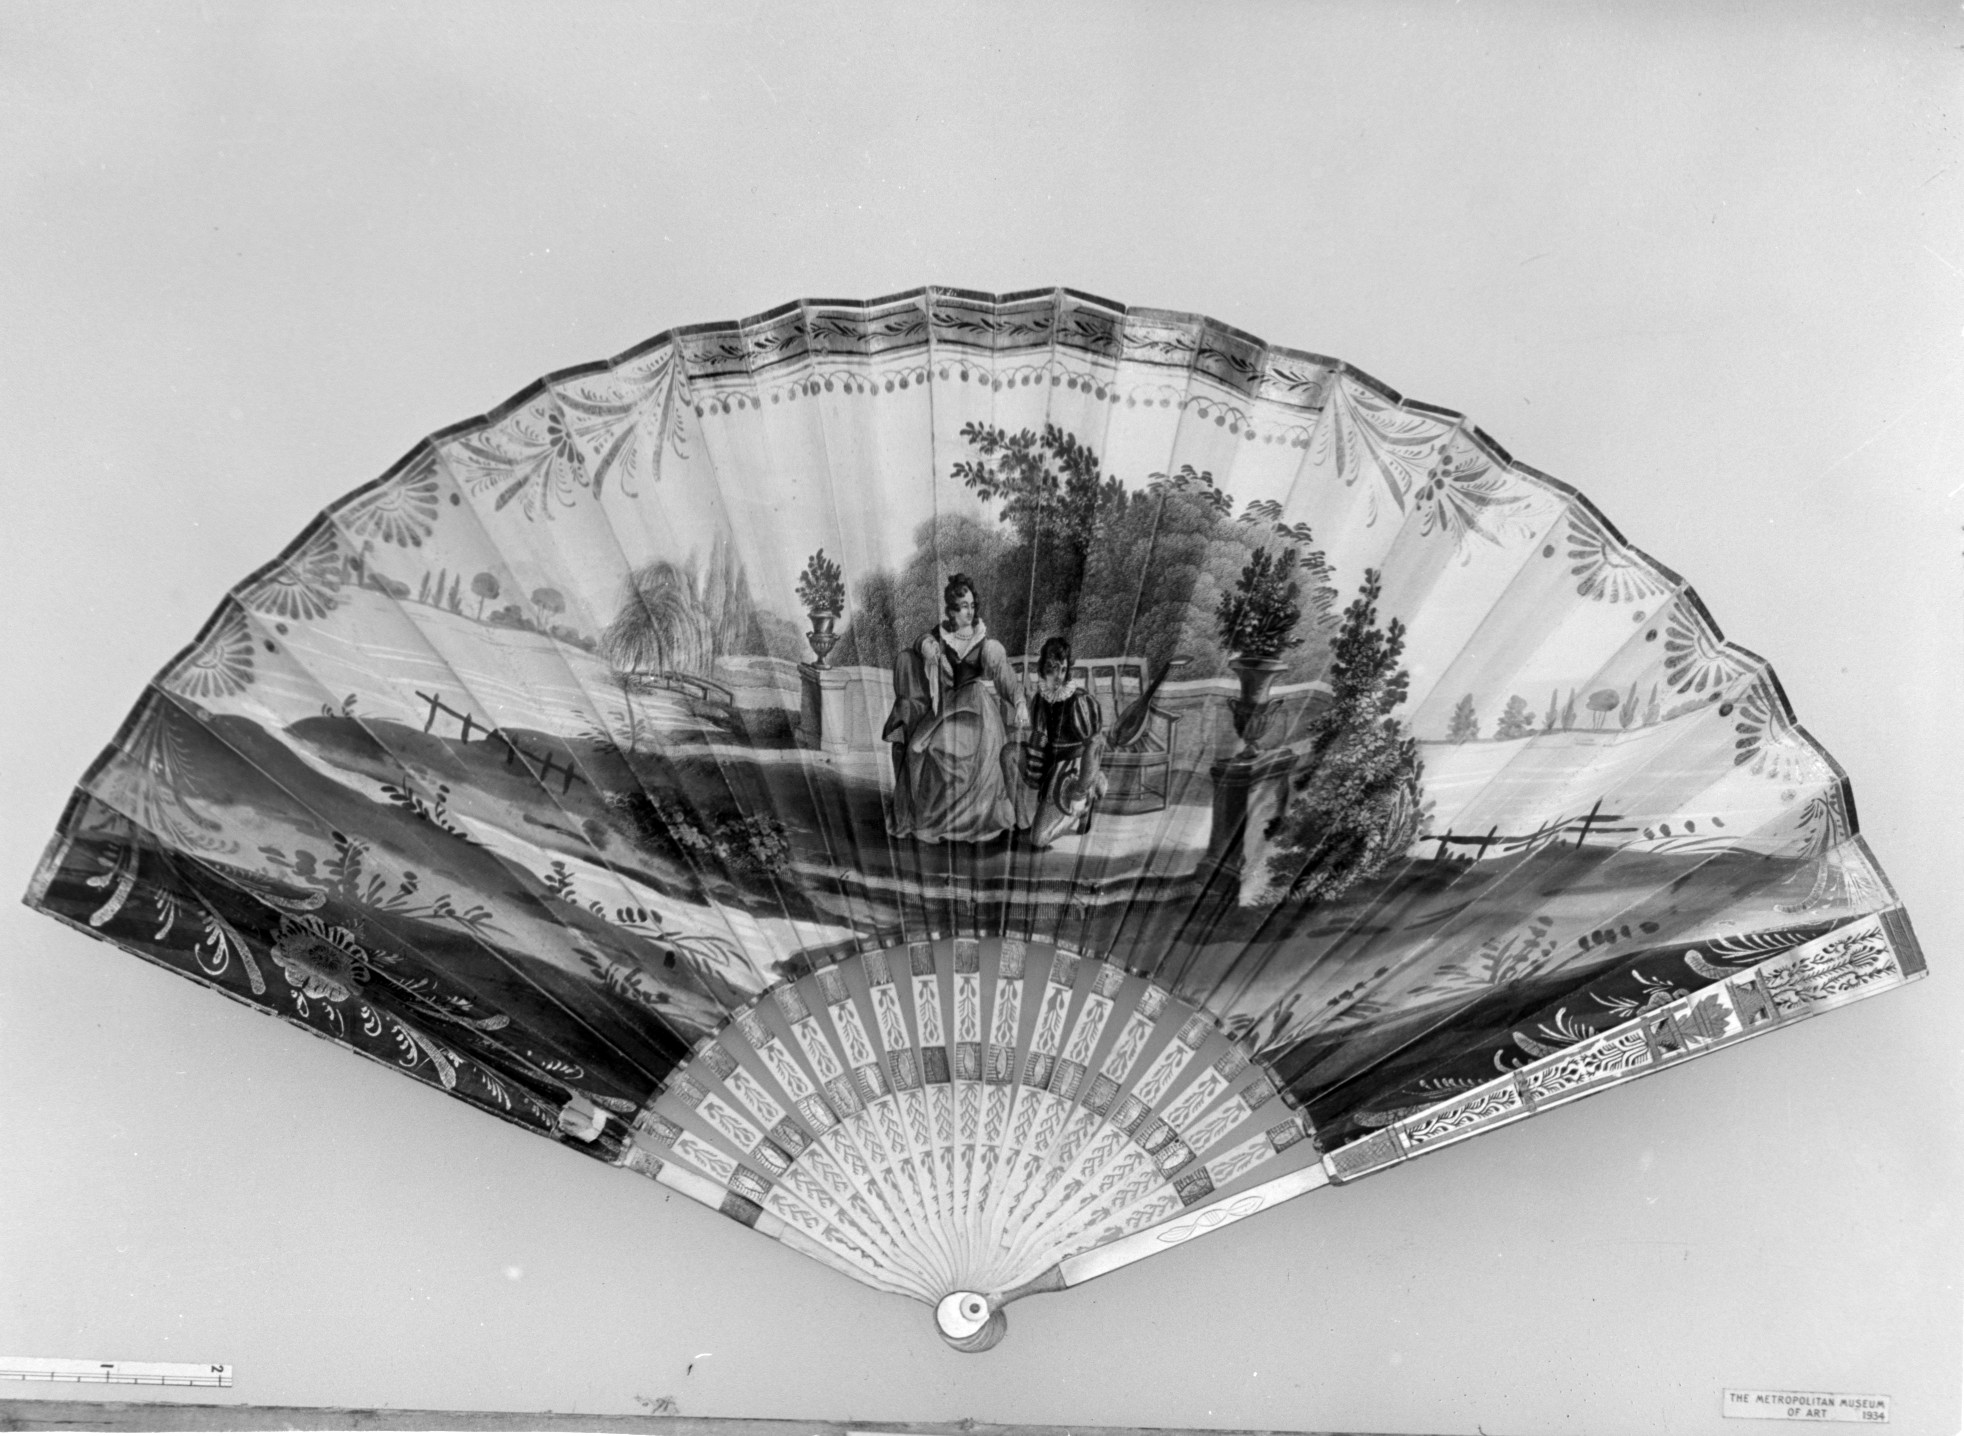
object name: fan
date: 1830-1840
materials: gold foil, ivory, mother of pearl, paper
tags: musical instruments,men,women